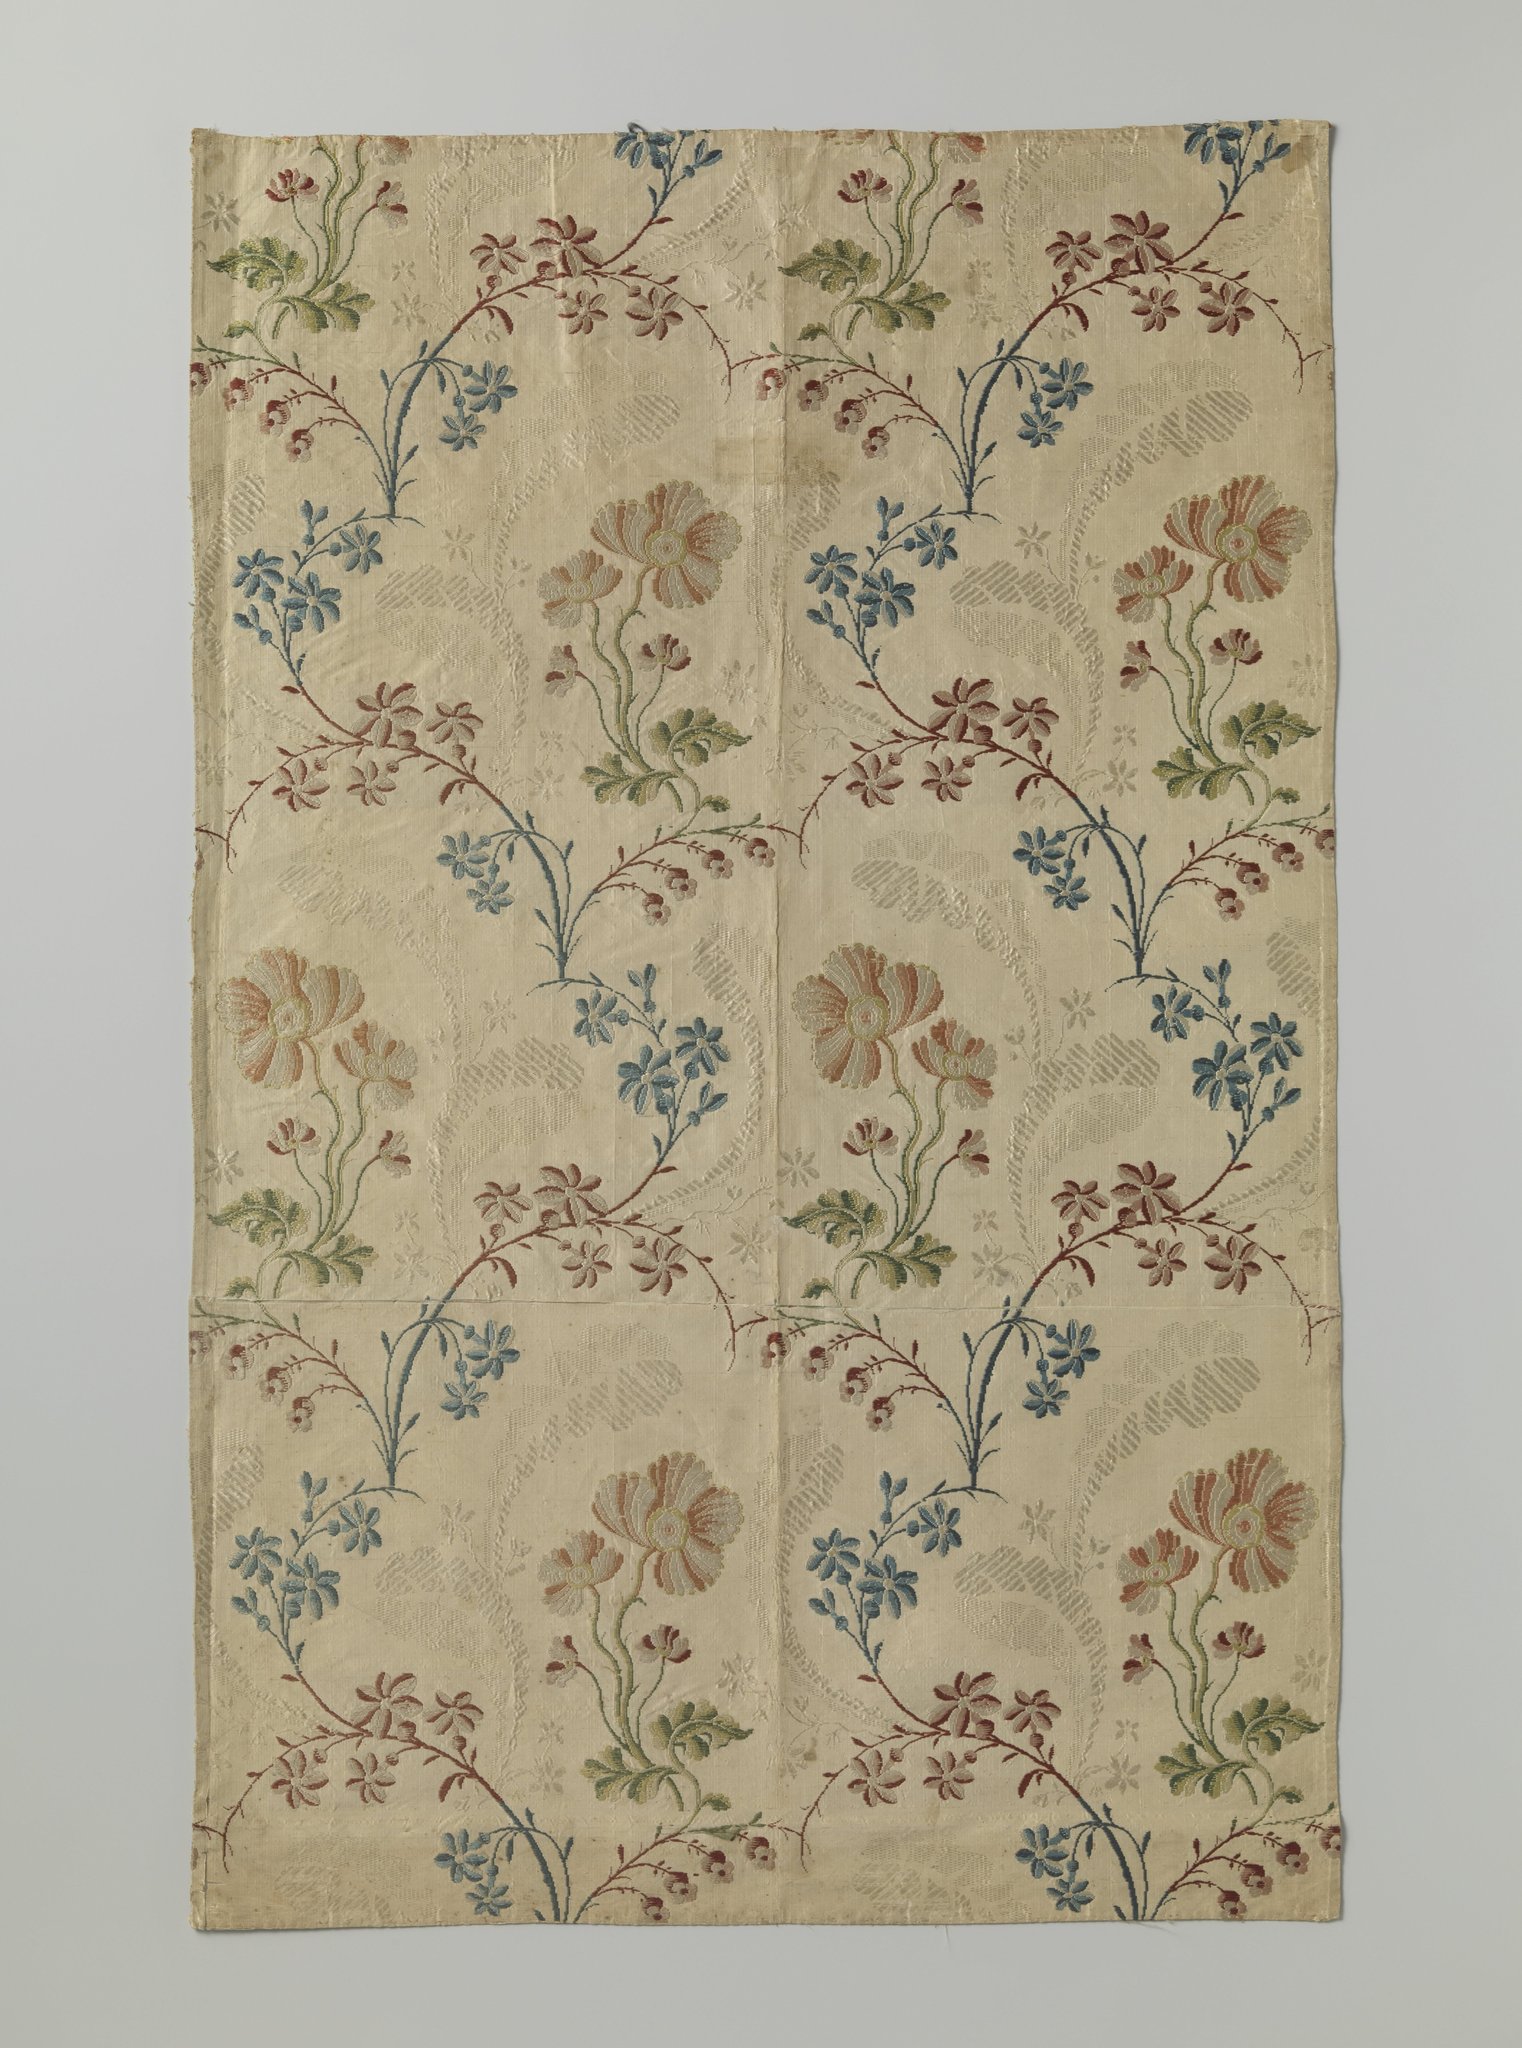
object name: woven material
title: Twee aan elkaar geplakte fragmenten veelkleurige gebrocheerde zijde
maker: Anonymous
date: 1730-1760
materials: silk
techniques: brocade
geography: netherlands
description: Twee fragmenten zijdeweefsel. Het patroon heeft witte veervormige bladeren met kleine bloemen en veelkleurige bloemtakken.